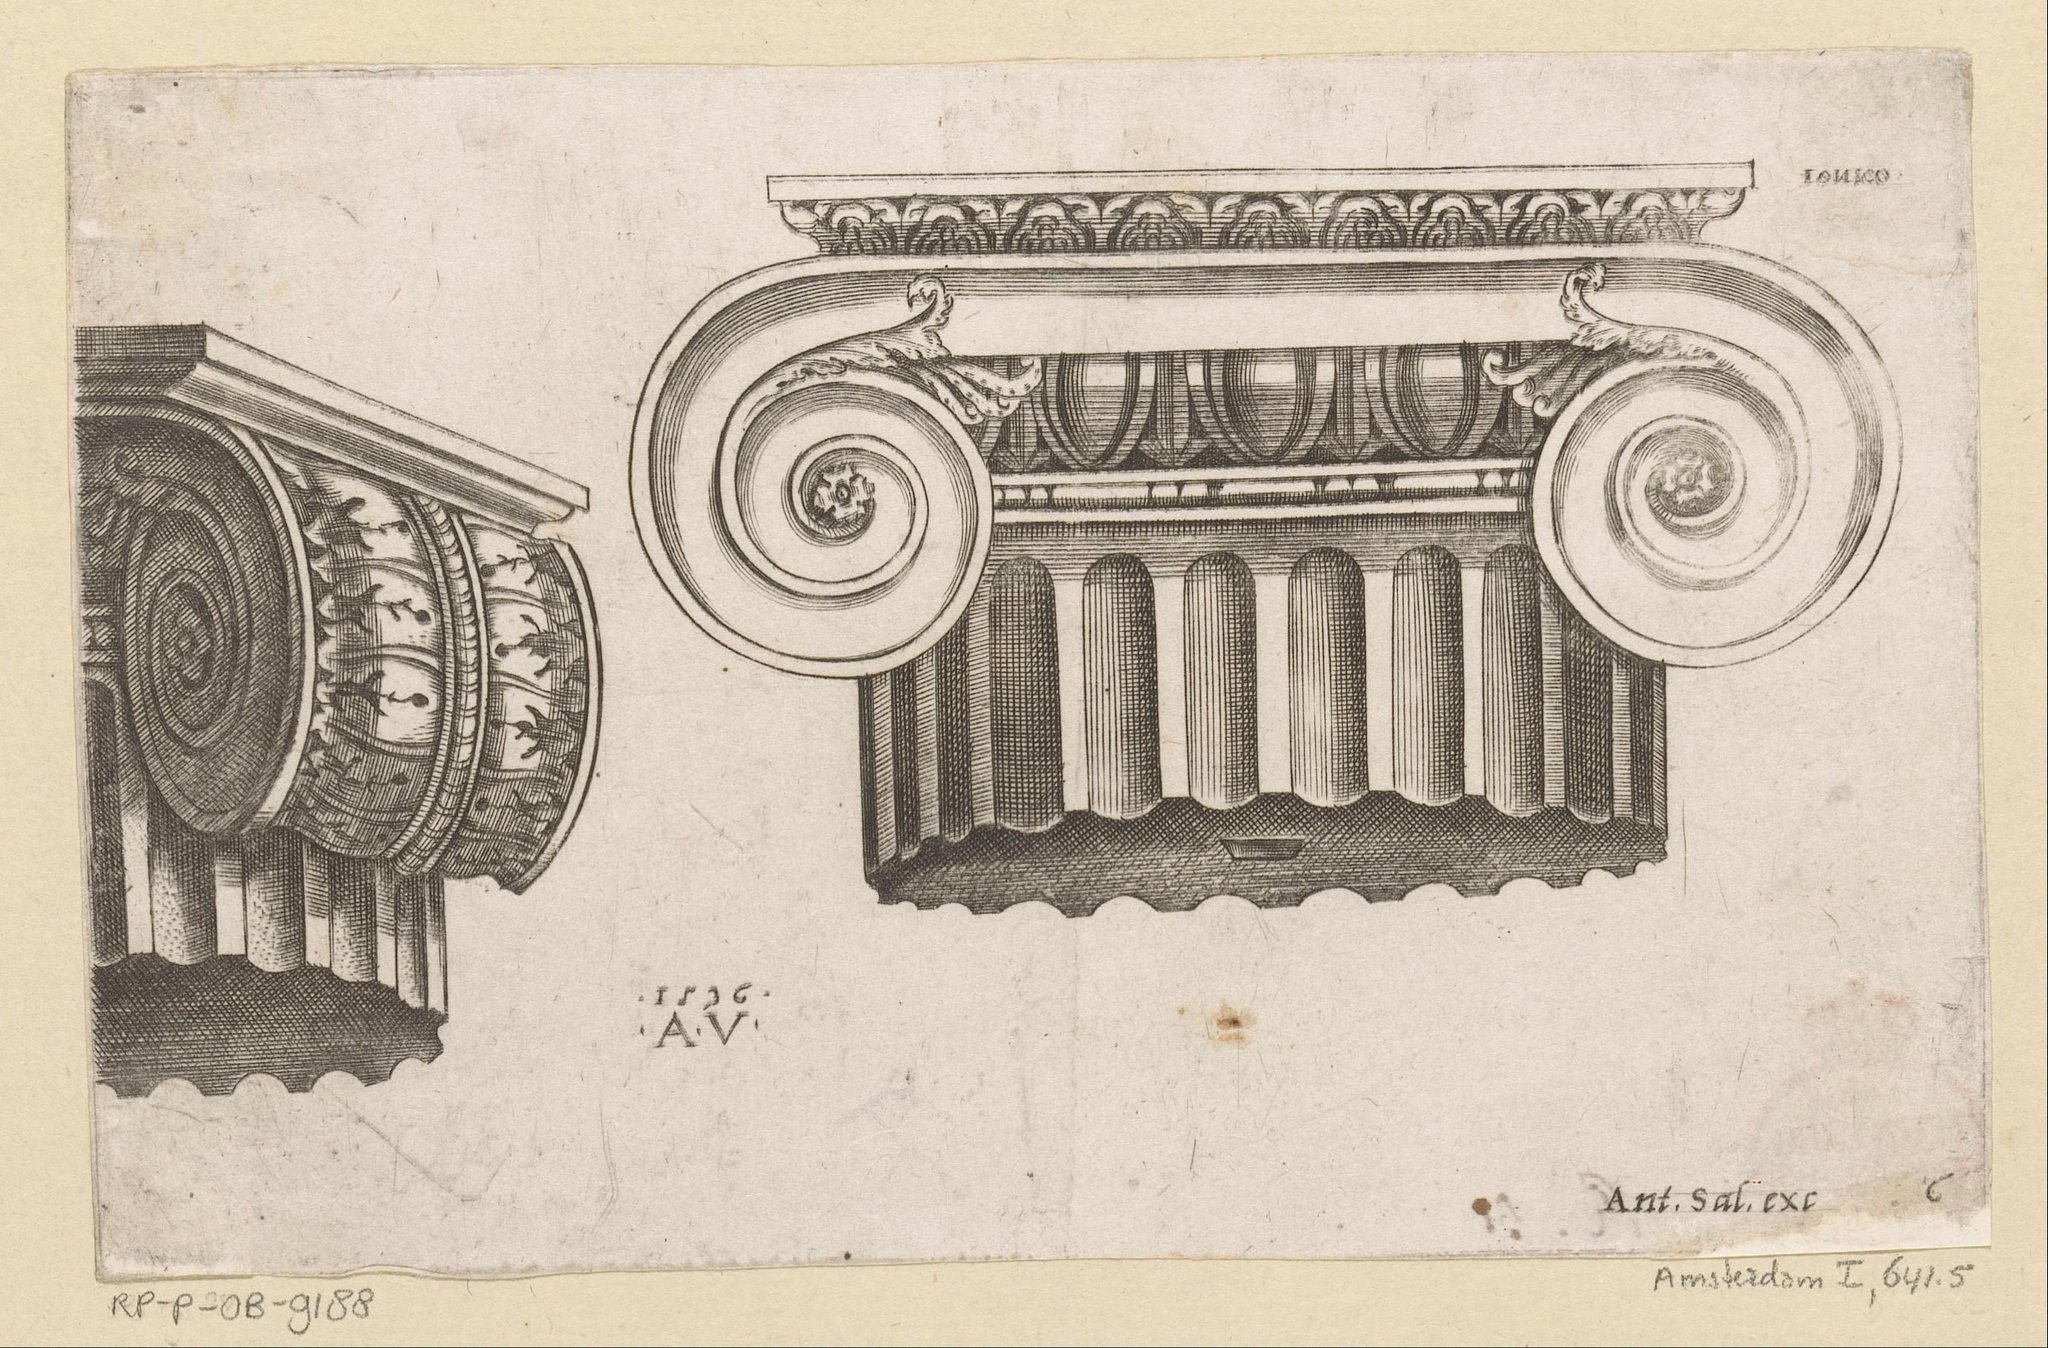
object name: ornament print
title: Antieke bouwfragmenten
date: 1536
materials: paper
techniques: engraving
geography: rome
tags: capital (~ column, pillar)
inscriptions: collector's mark: Lugt 12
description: Deze prent maakt deel uit van een reeks van negen prenten met antieke bouwfragmenten. De nummering op de prenten wijkt af.